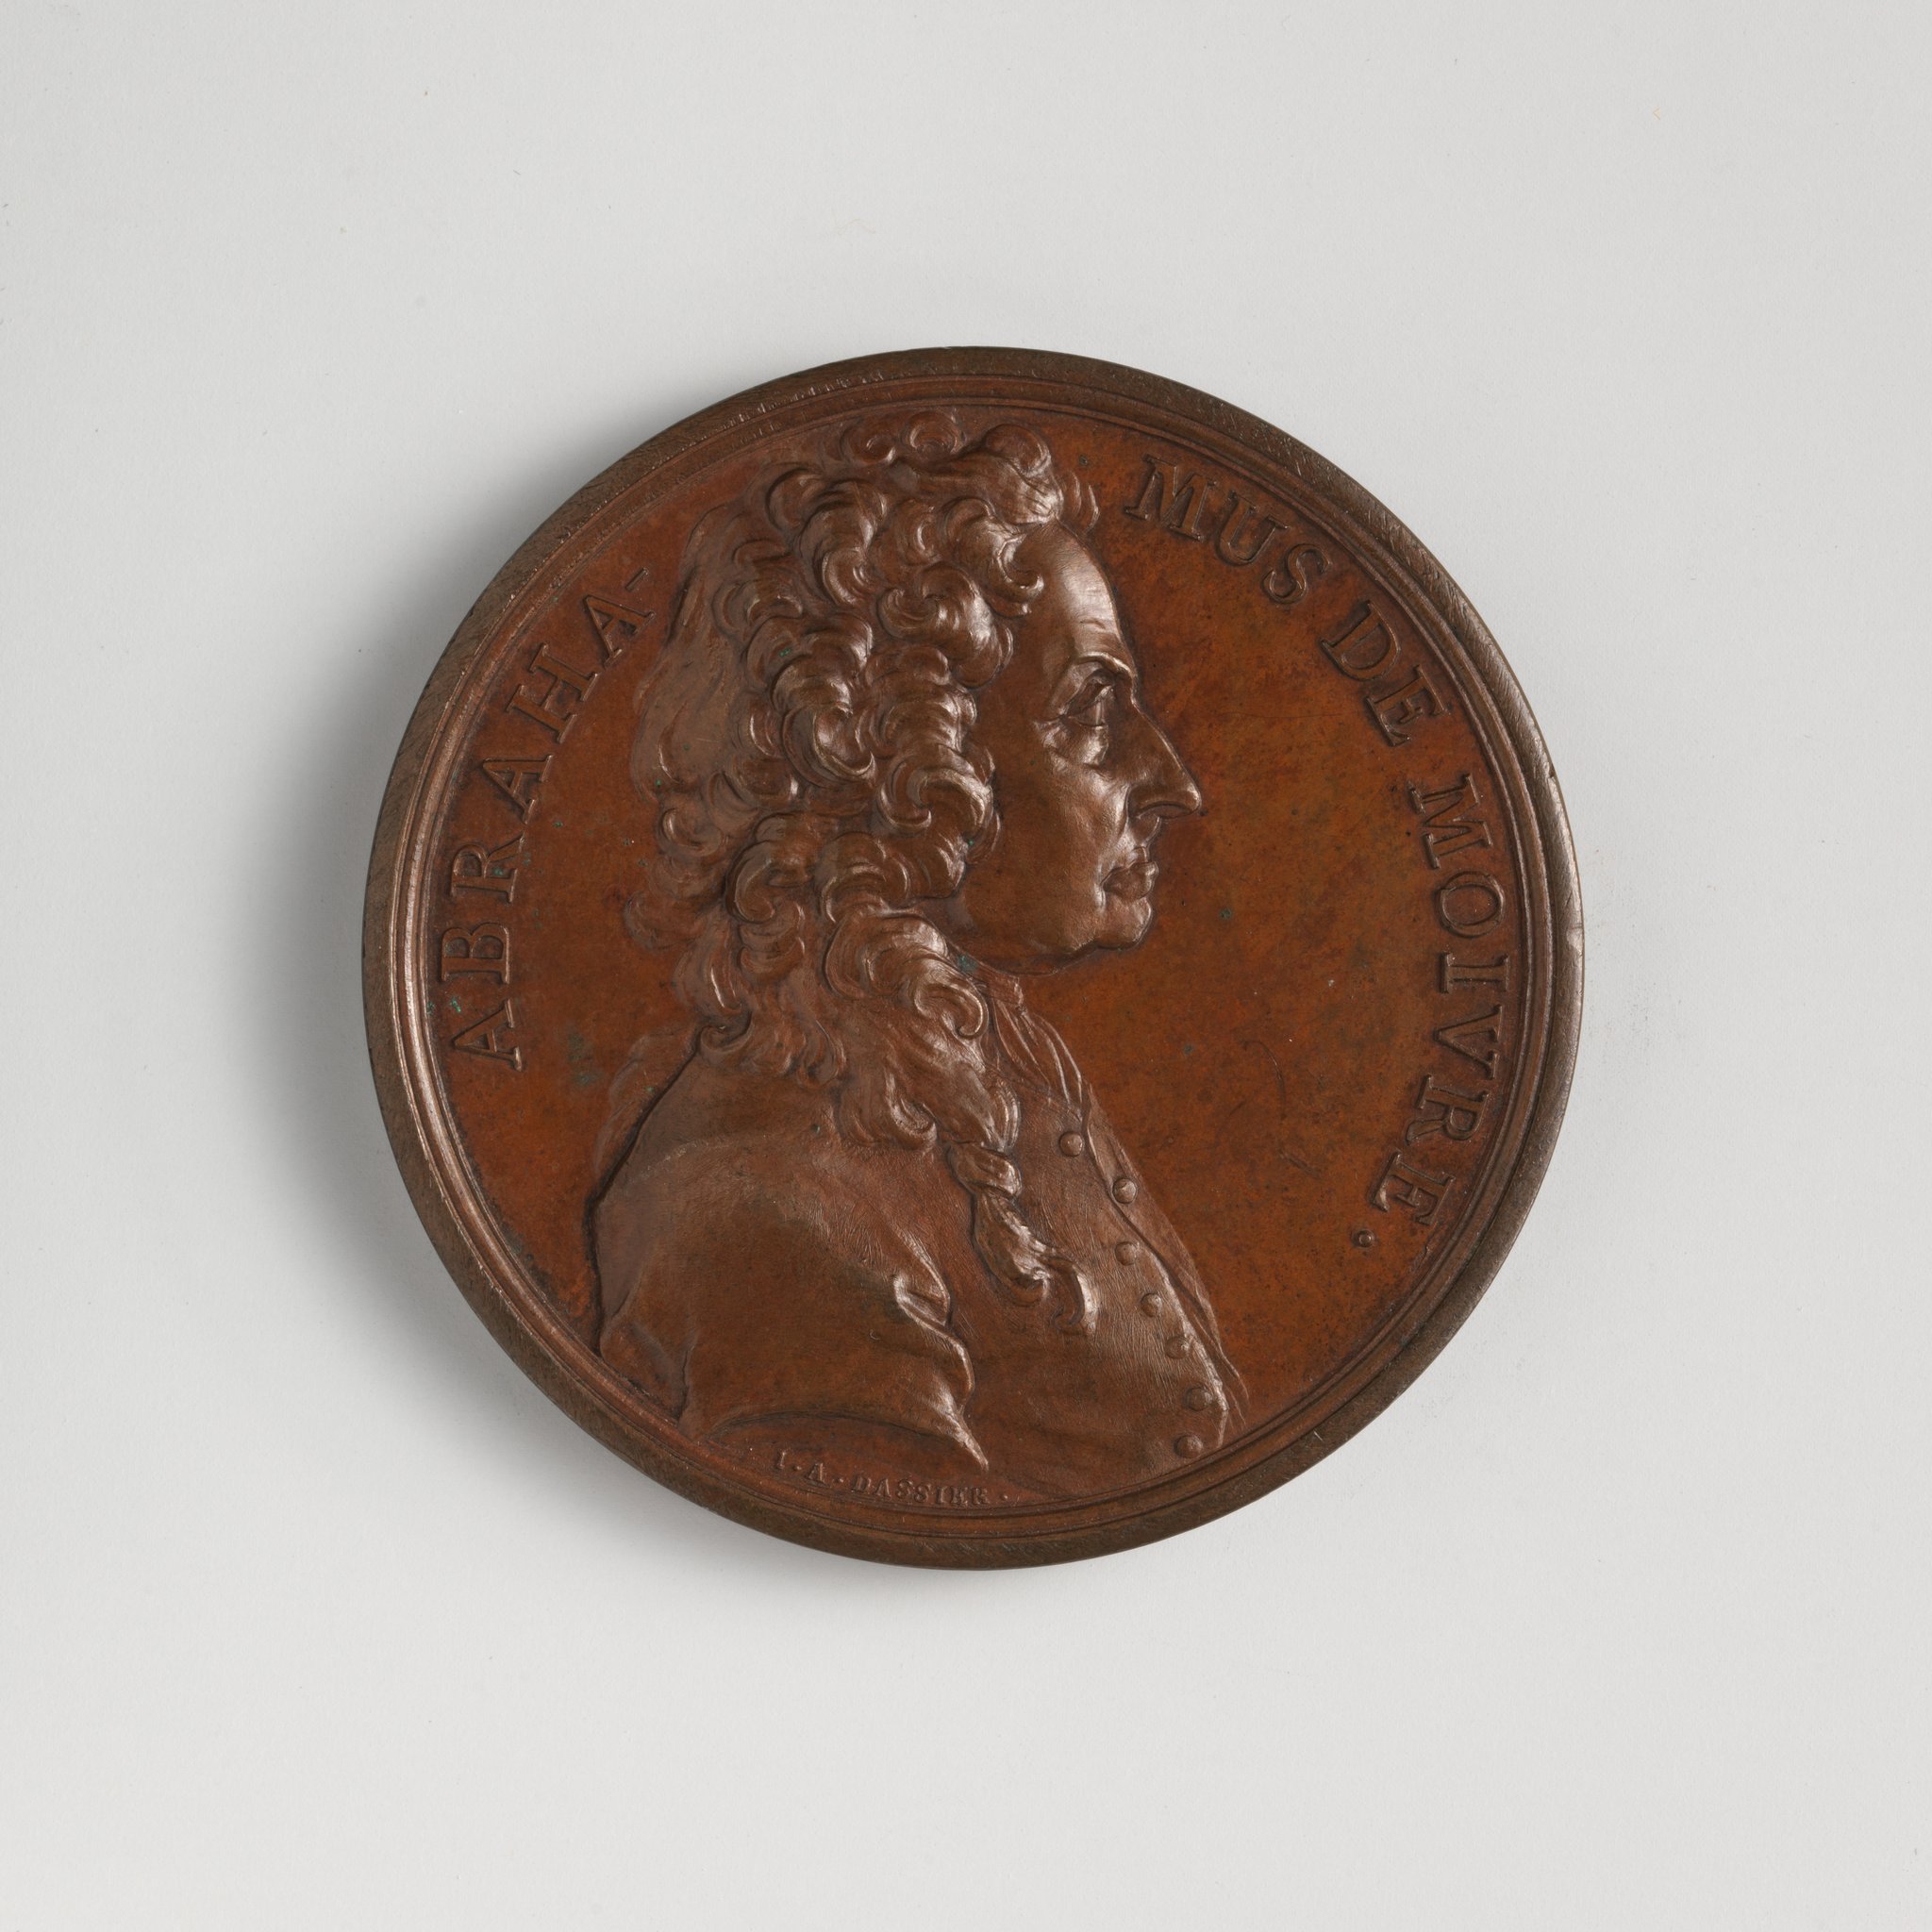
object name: medal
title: Abraham de Moivre (1667–1754)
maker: jacques-antoine dassier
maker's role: artist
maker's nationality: swiss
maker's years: 1715-1759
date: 1741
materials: bronze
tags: men,profiles